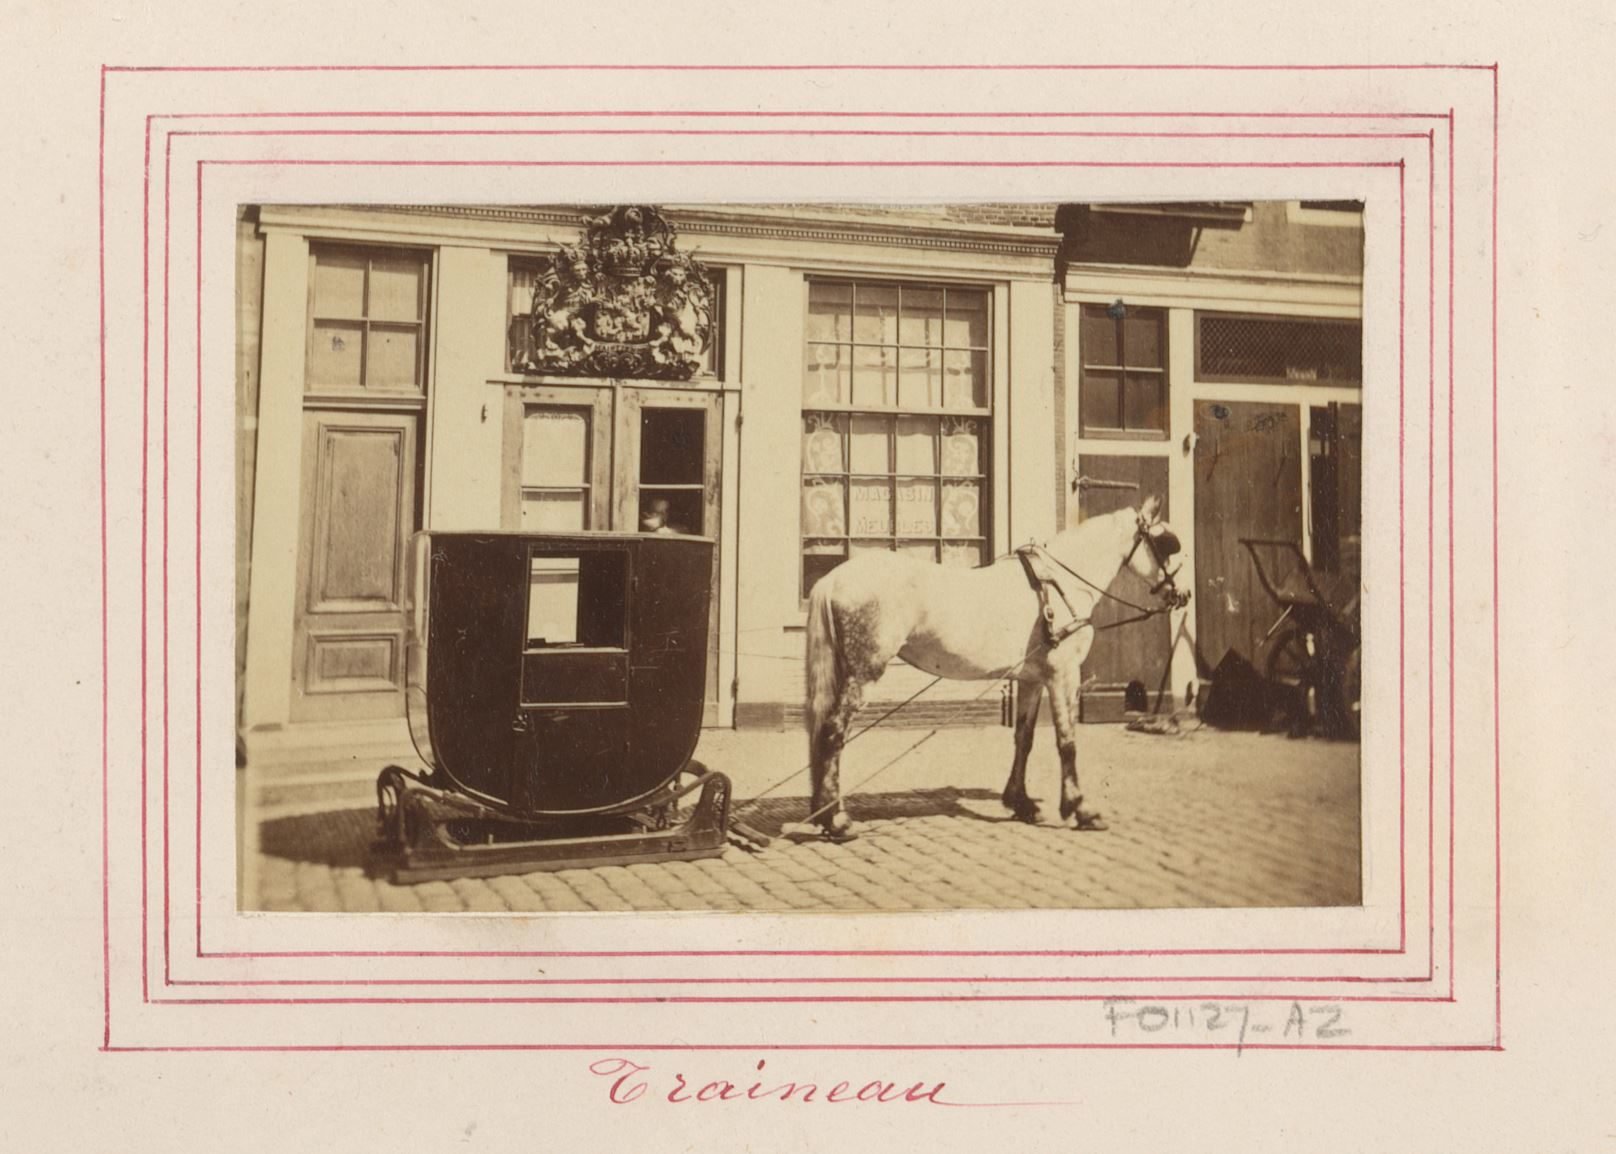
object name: photograph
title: Toeslede (sleepkoets) op straat in Amsterdam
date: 1870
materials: photographic support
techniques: albumen print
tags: horse-sleigh, animal-drawn sledge (dutch: 'toeslede')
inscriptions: inscription: ‘traineau’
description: Onderdeel van Album met foto's en litho's van bezienswaardigheden in Noord- en Zuid-Hollandse steden, schilderijen en klederdrachten.